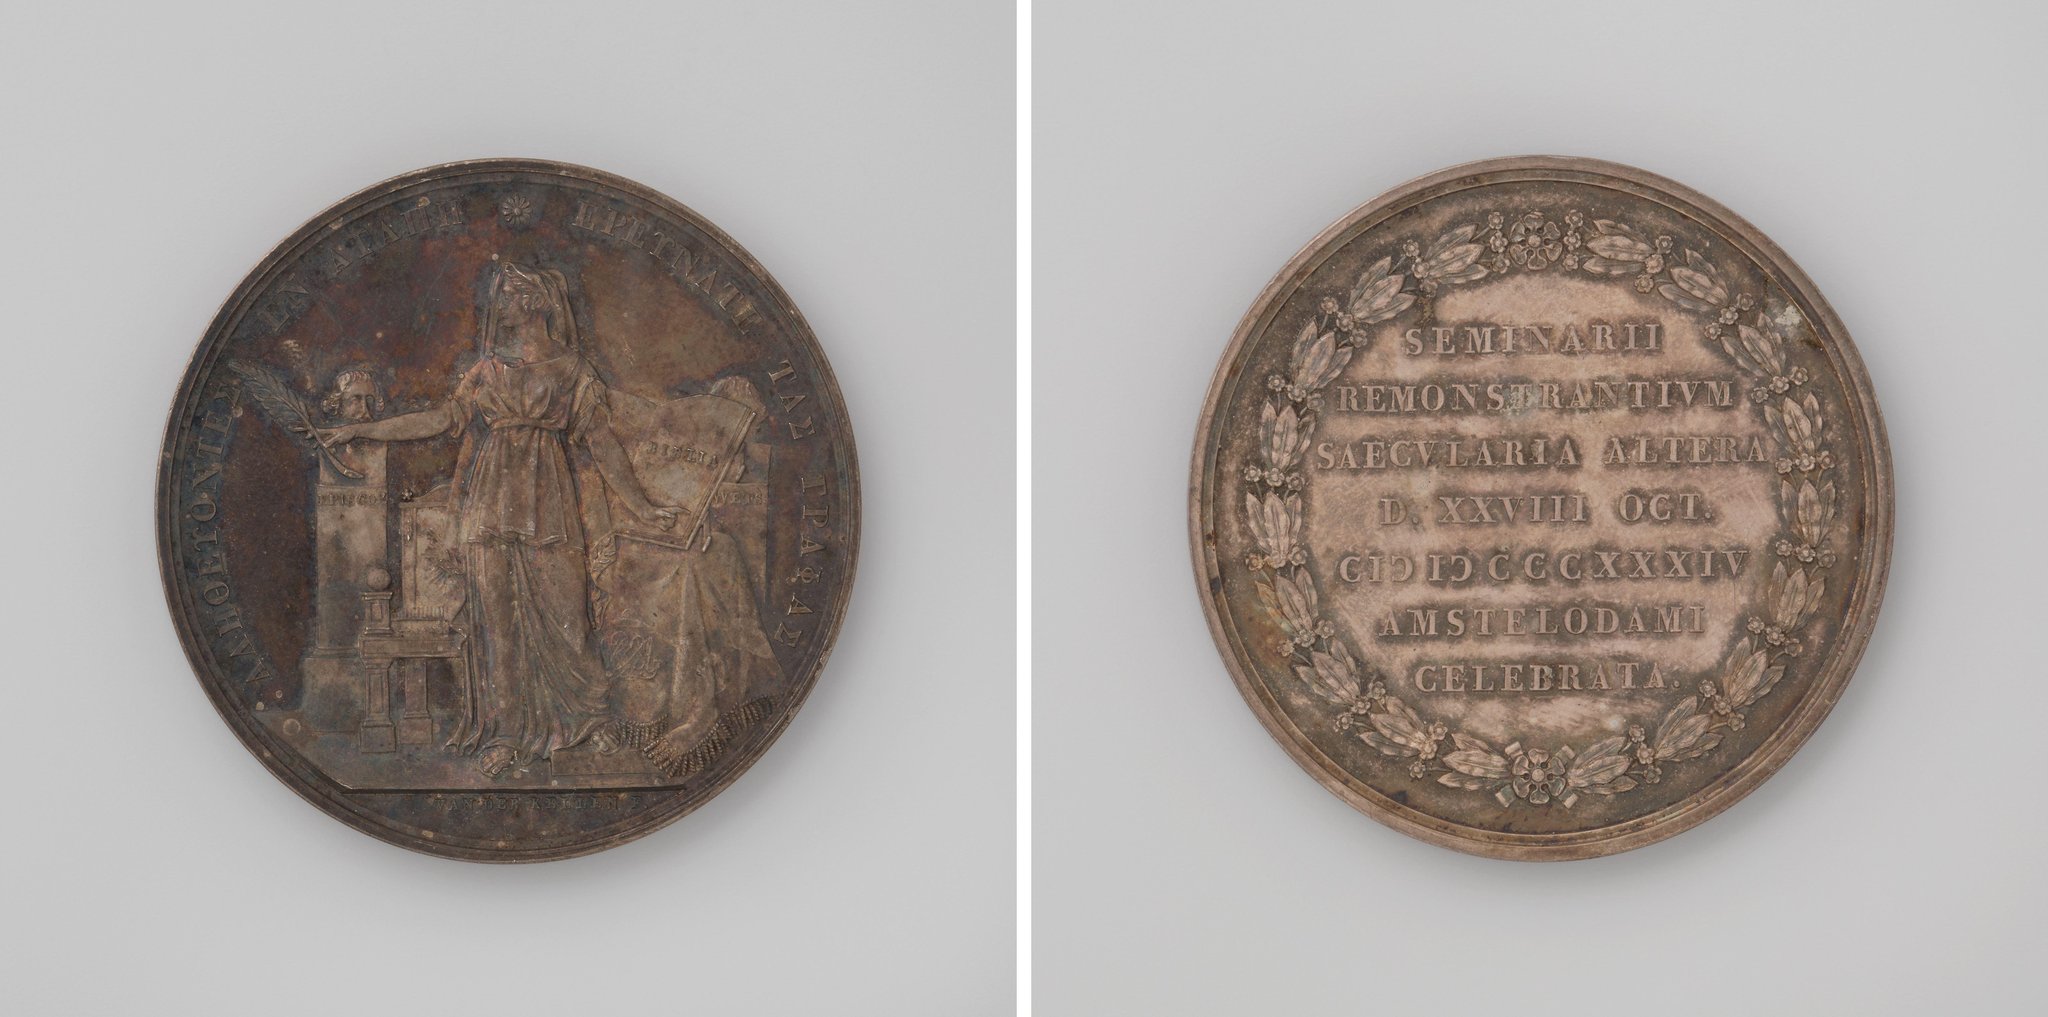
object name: history medal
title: Tweehonderdjarig bestaan van het Remonstrants seminarie te Amsterdam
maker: david van der kellen (1804-1879)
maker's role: die cutter, draughtsman, print maker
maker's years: 1804-1879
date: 1834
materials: silver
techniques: striking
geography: utrecht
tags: amsterdam